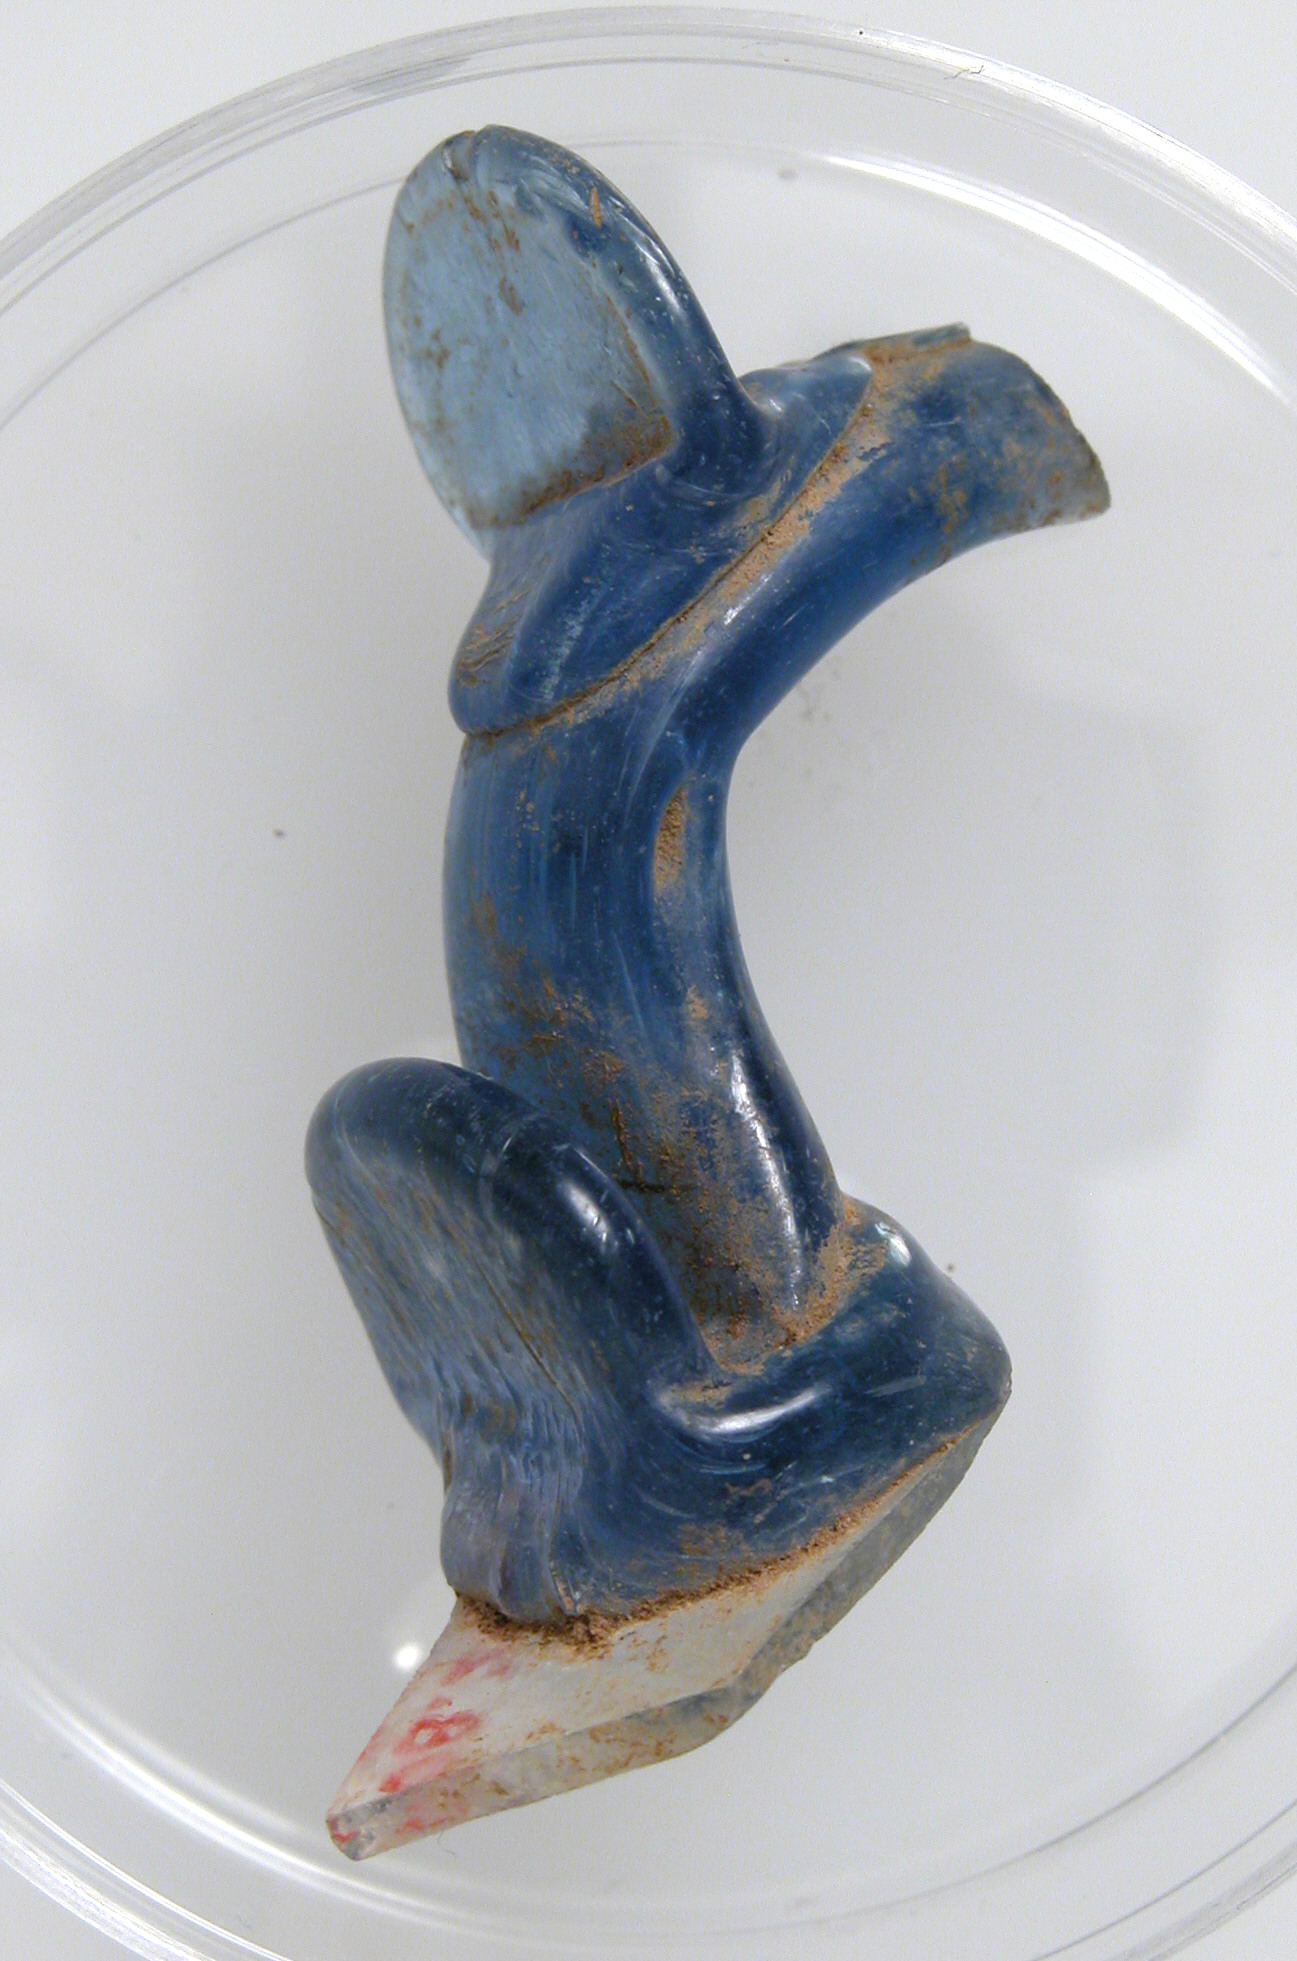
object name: fragment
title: Handle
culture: coptic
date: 301-433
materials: glass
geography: egypt